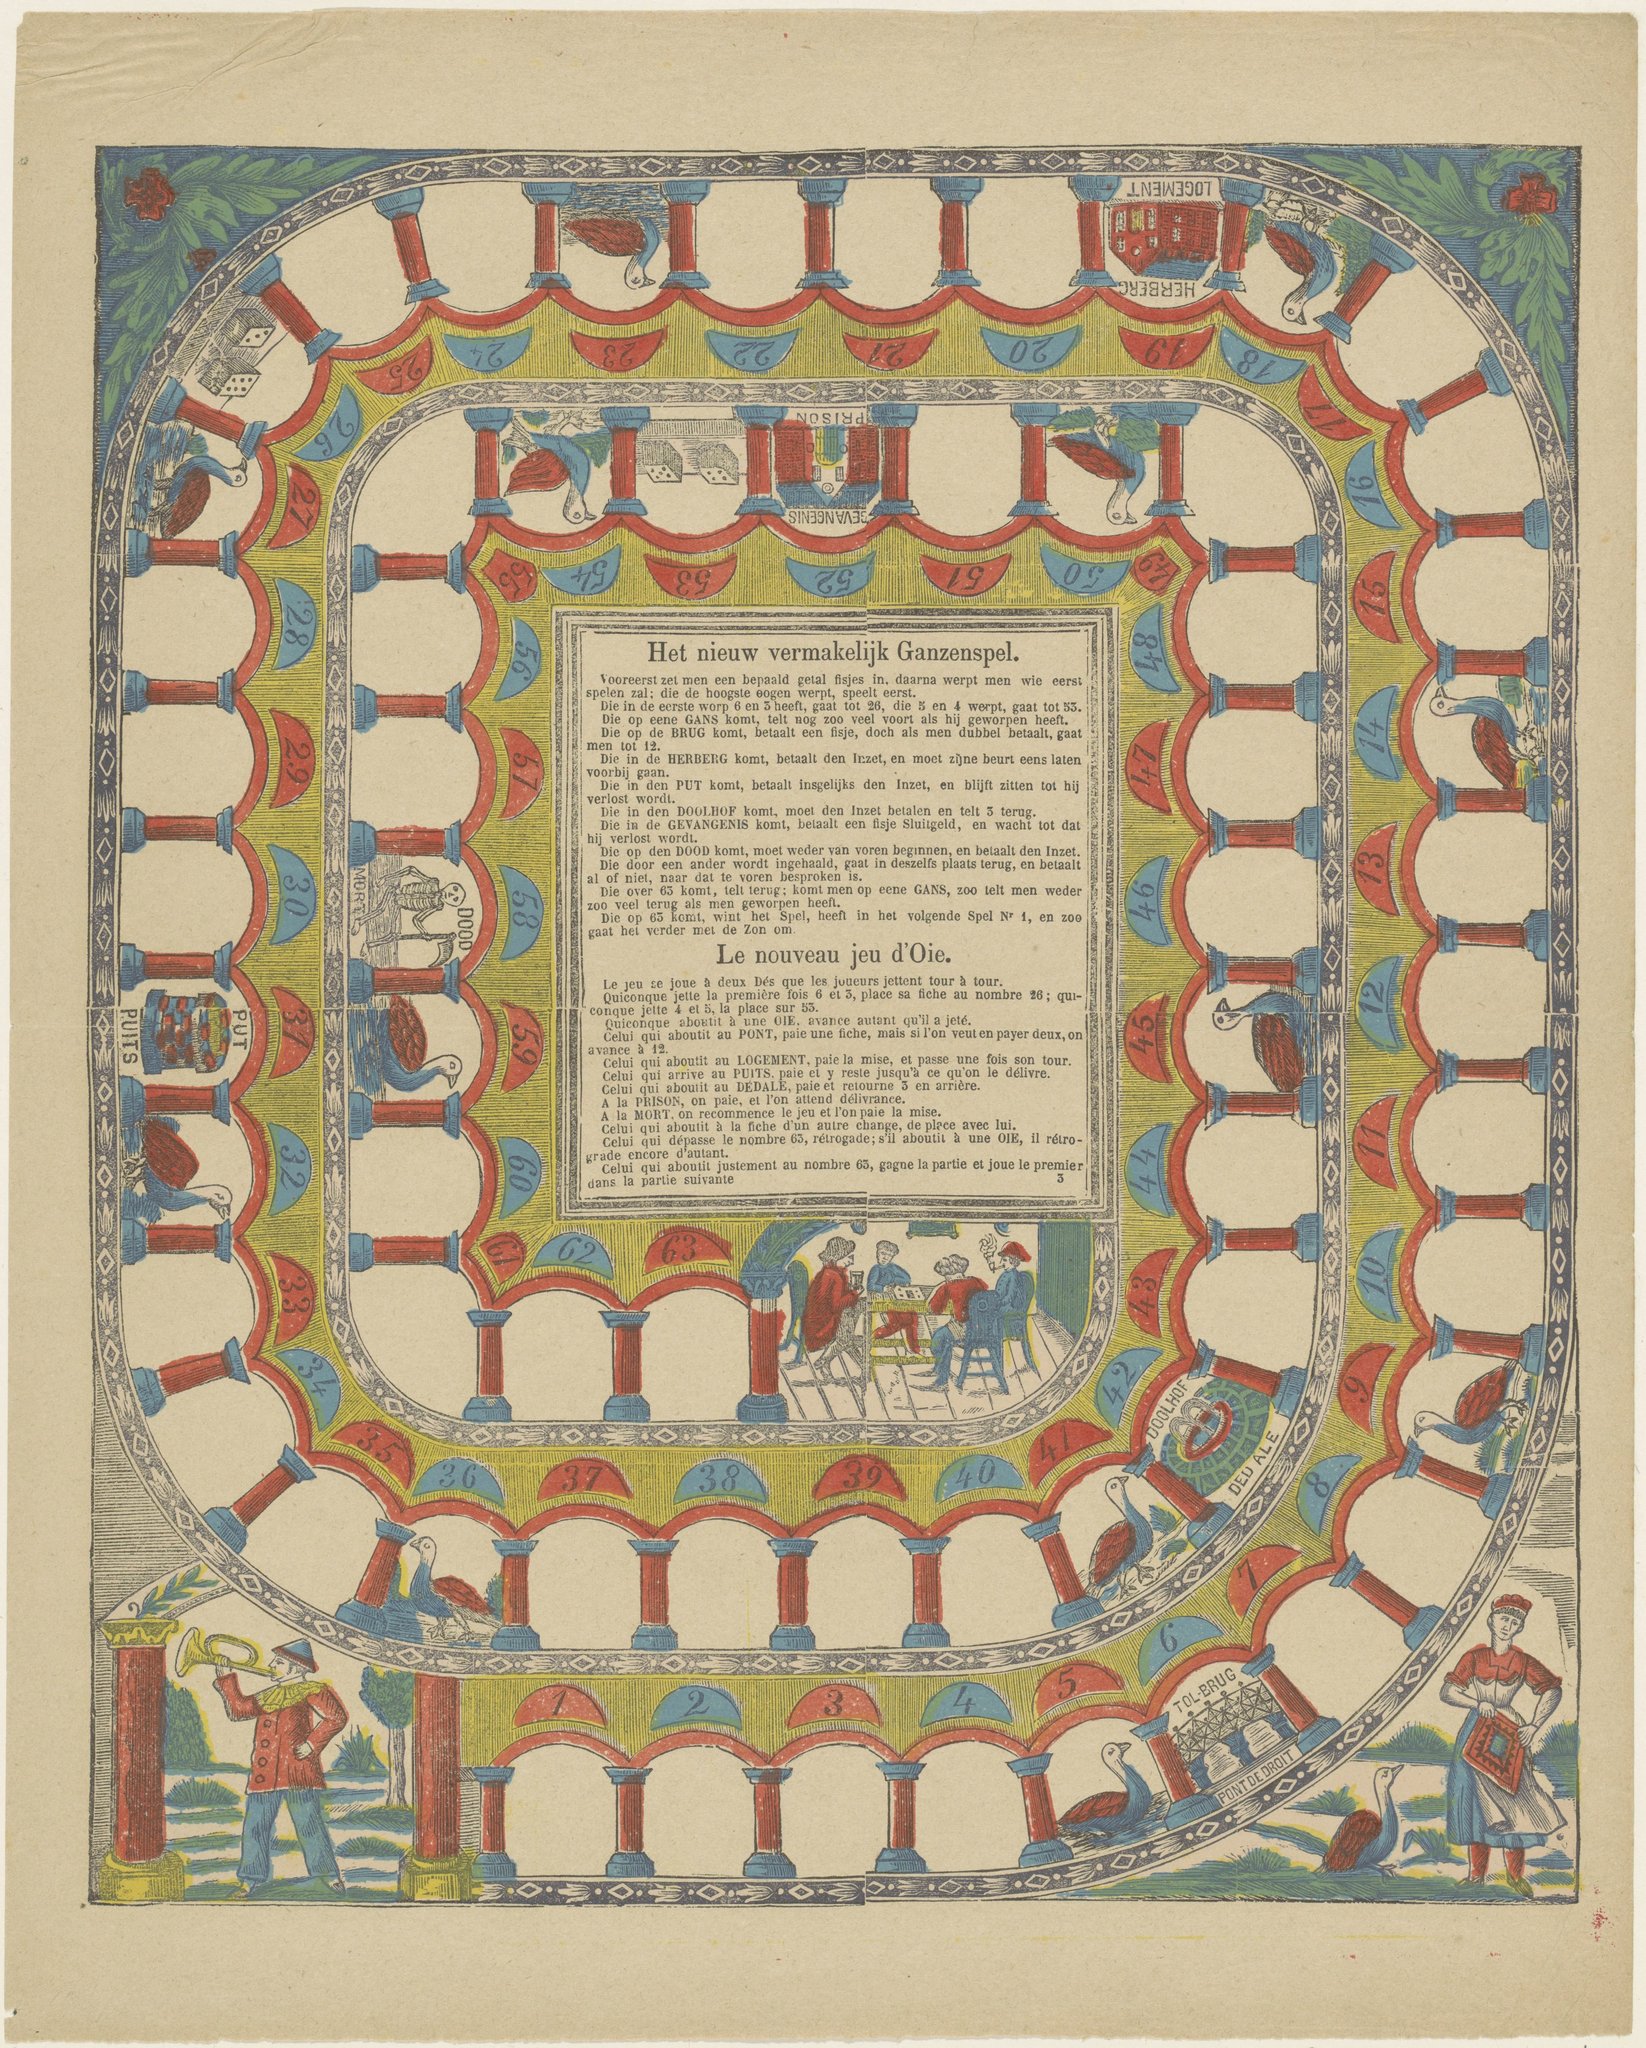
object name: popular print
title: Het nieuw vermakelijk / ganzenspel / Le nouveau jeu d'Oie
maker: Anonymous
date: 1833-1911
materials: paper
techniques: lithograph, letterpress printing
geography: turnhout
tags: goose-game, board-games of chance, board-games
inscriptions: collector's mark: Lugt 2760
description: Ganzenbordspel met spiraal met 63 genummerde vakjes. In verschillende vakjes een voorstelling van een gans. Op het middenveld de titel en spelregels in het Nederlands en in het Frans in boekdruk. Rechtsonder in het middenveld genummerd: 3.